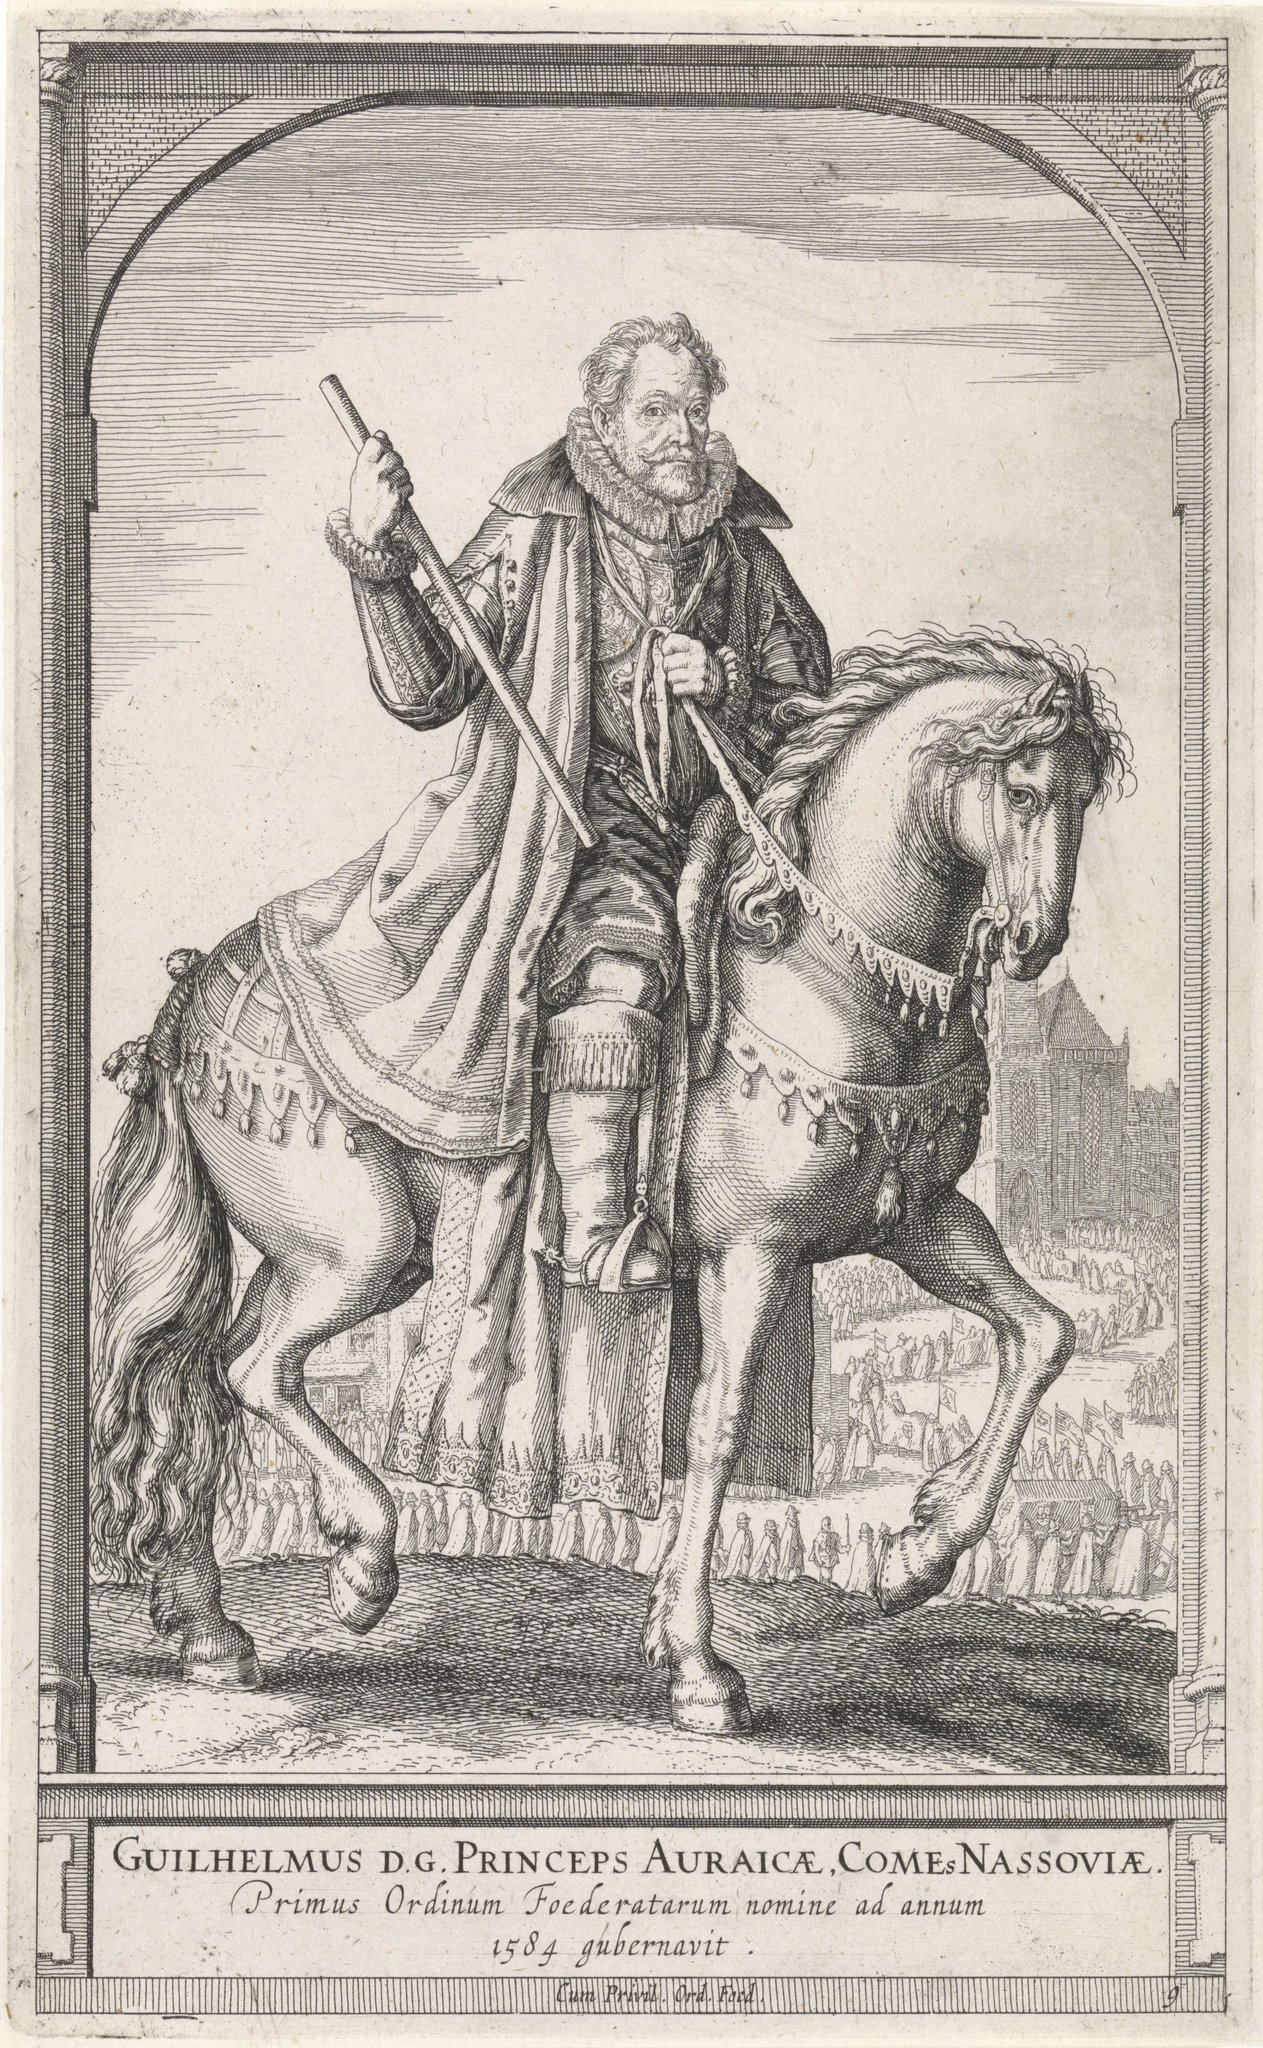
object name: print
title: Ruiterportret van Willem van Oranje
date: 1591-1632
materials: paper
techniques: etching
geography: amsterdam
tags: william i (prince of orange), riding a horse, ass, or mule; rider, horseman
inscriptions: collector's mark: Lugt 2228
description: Willem van Oranje, prins van oranje en stadhouder van Holland, Zeeland en Utrecht, te paard. Naar rechts. Hij heeft een staf in de hand. Op de achtergrond zijn begrafenisstoet te Delft. De prent heeft een Latijns onderschrift en maakt deel uit van een serie ruiterportretten van Nederlandse landvoogden.